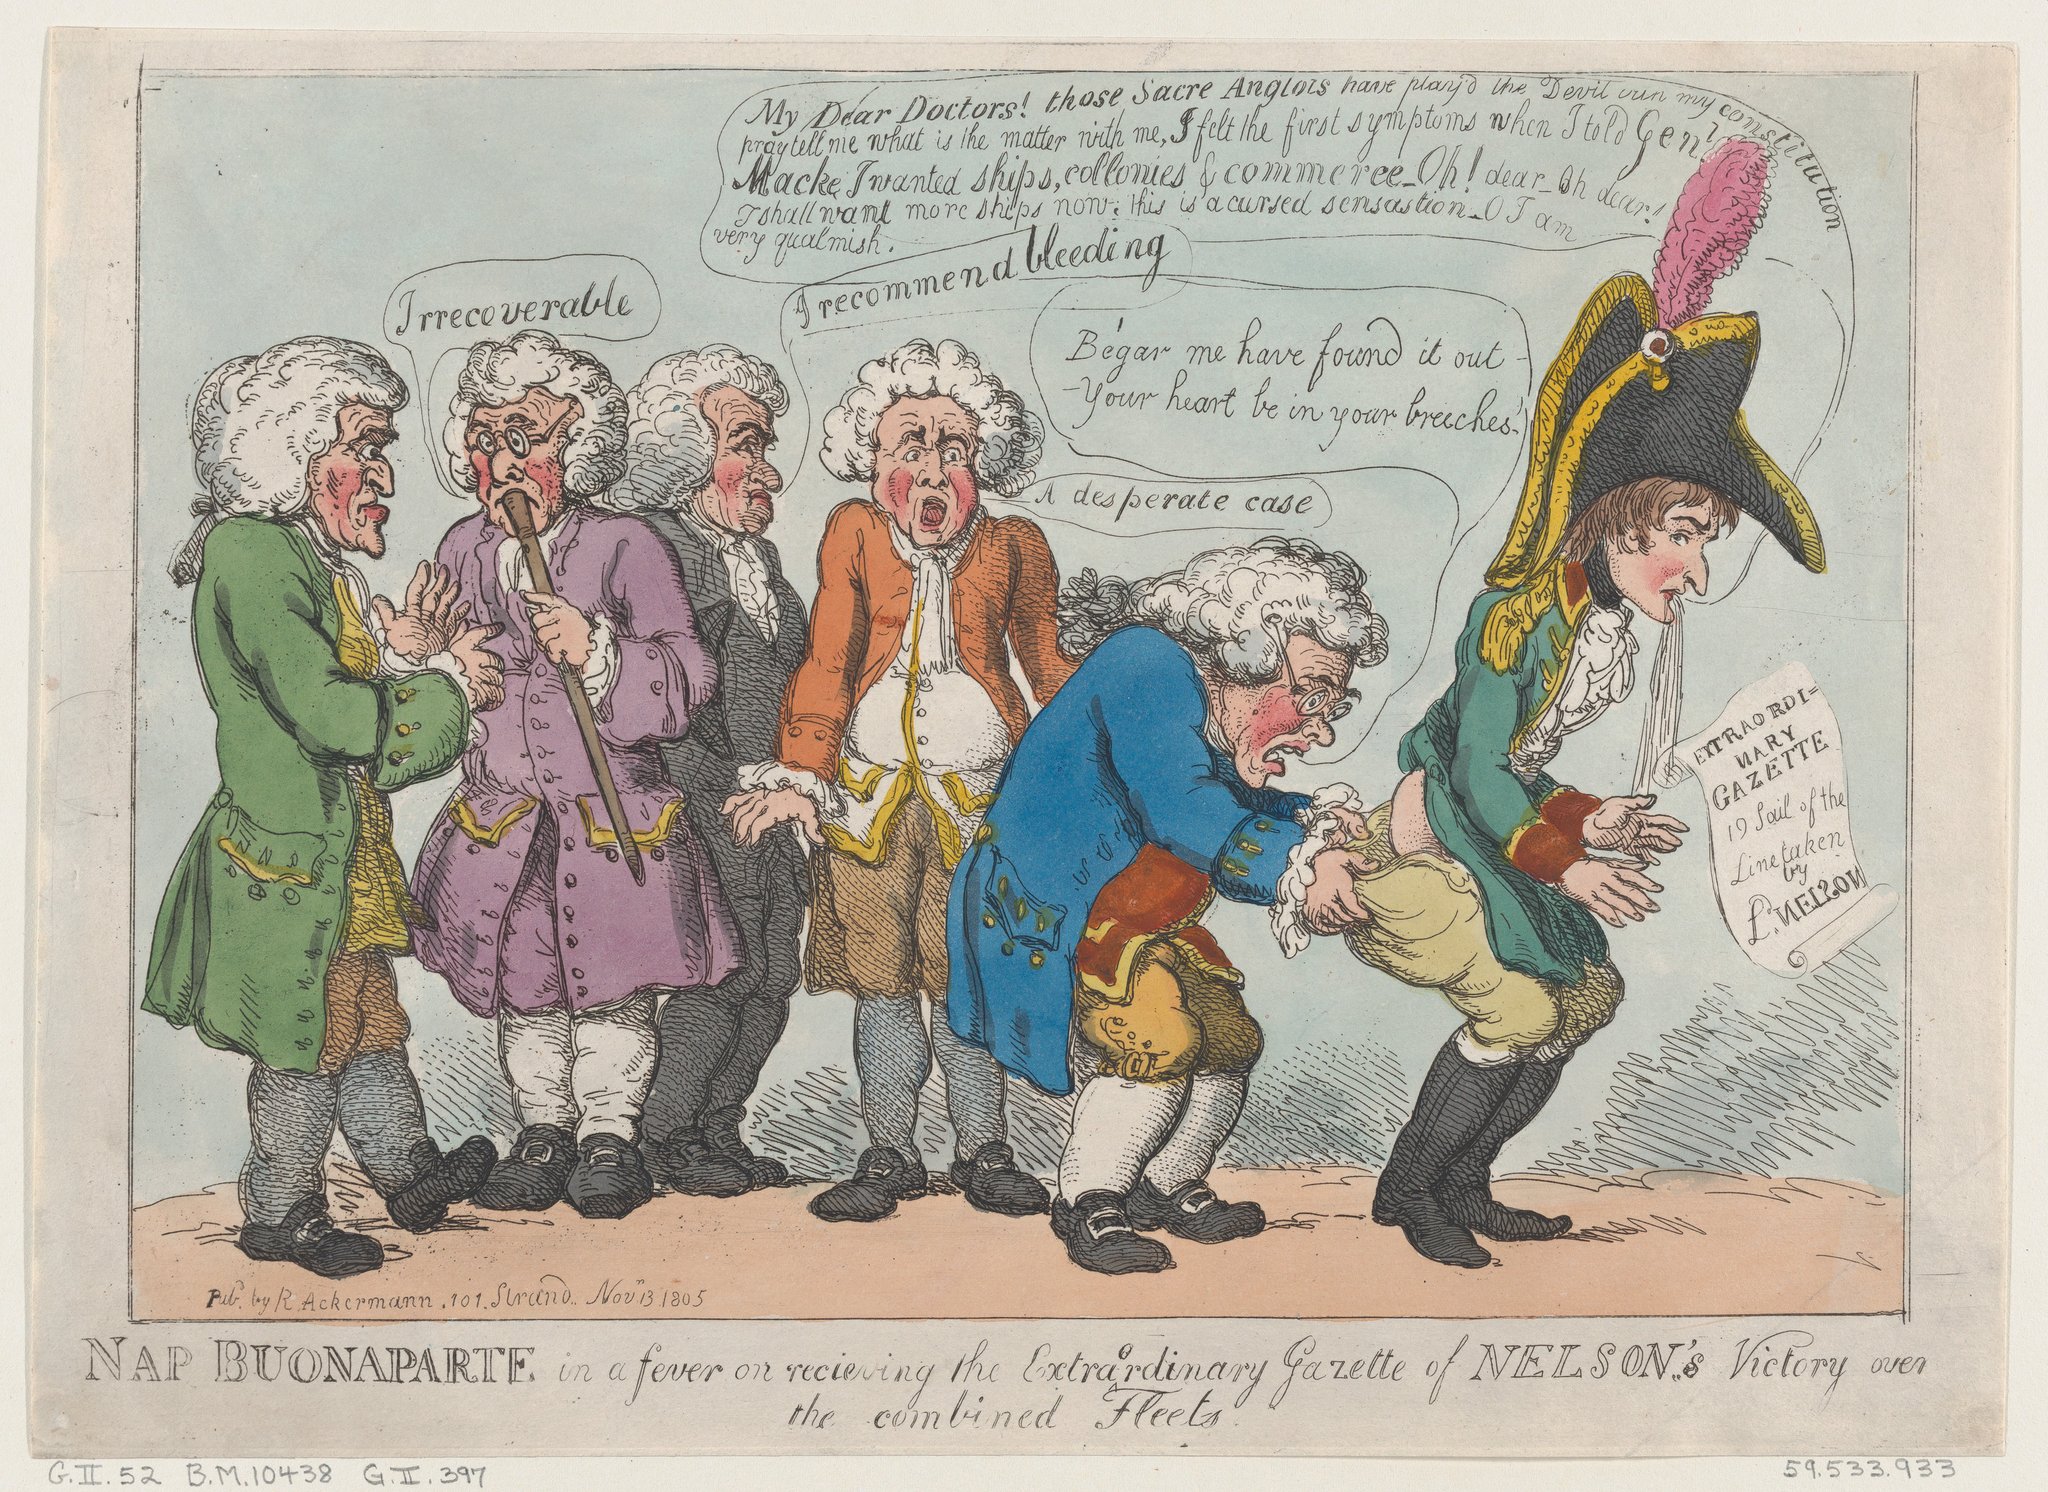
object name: print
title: Nap Buonaparte in a Fever on Receiving the Extraordinary Gazette of Nelson's Victory Over the Combined Fleets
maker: thomas rowlandson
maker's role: artist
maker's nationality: british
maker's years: 1757-1827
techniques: etching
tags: satire,napoleon i,men,politics